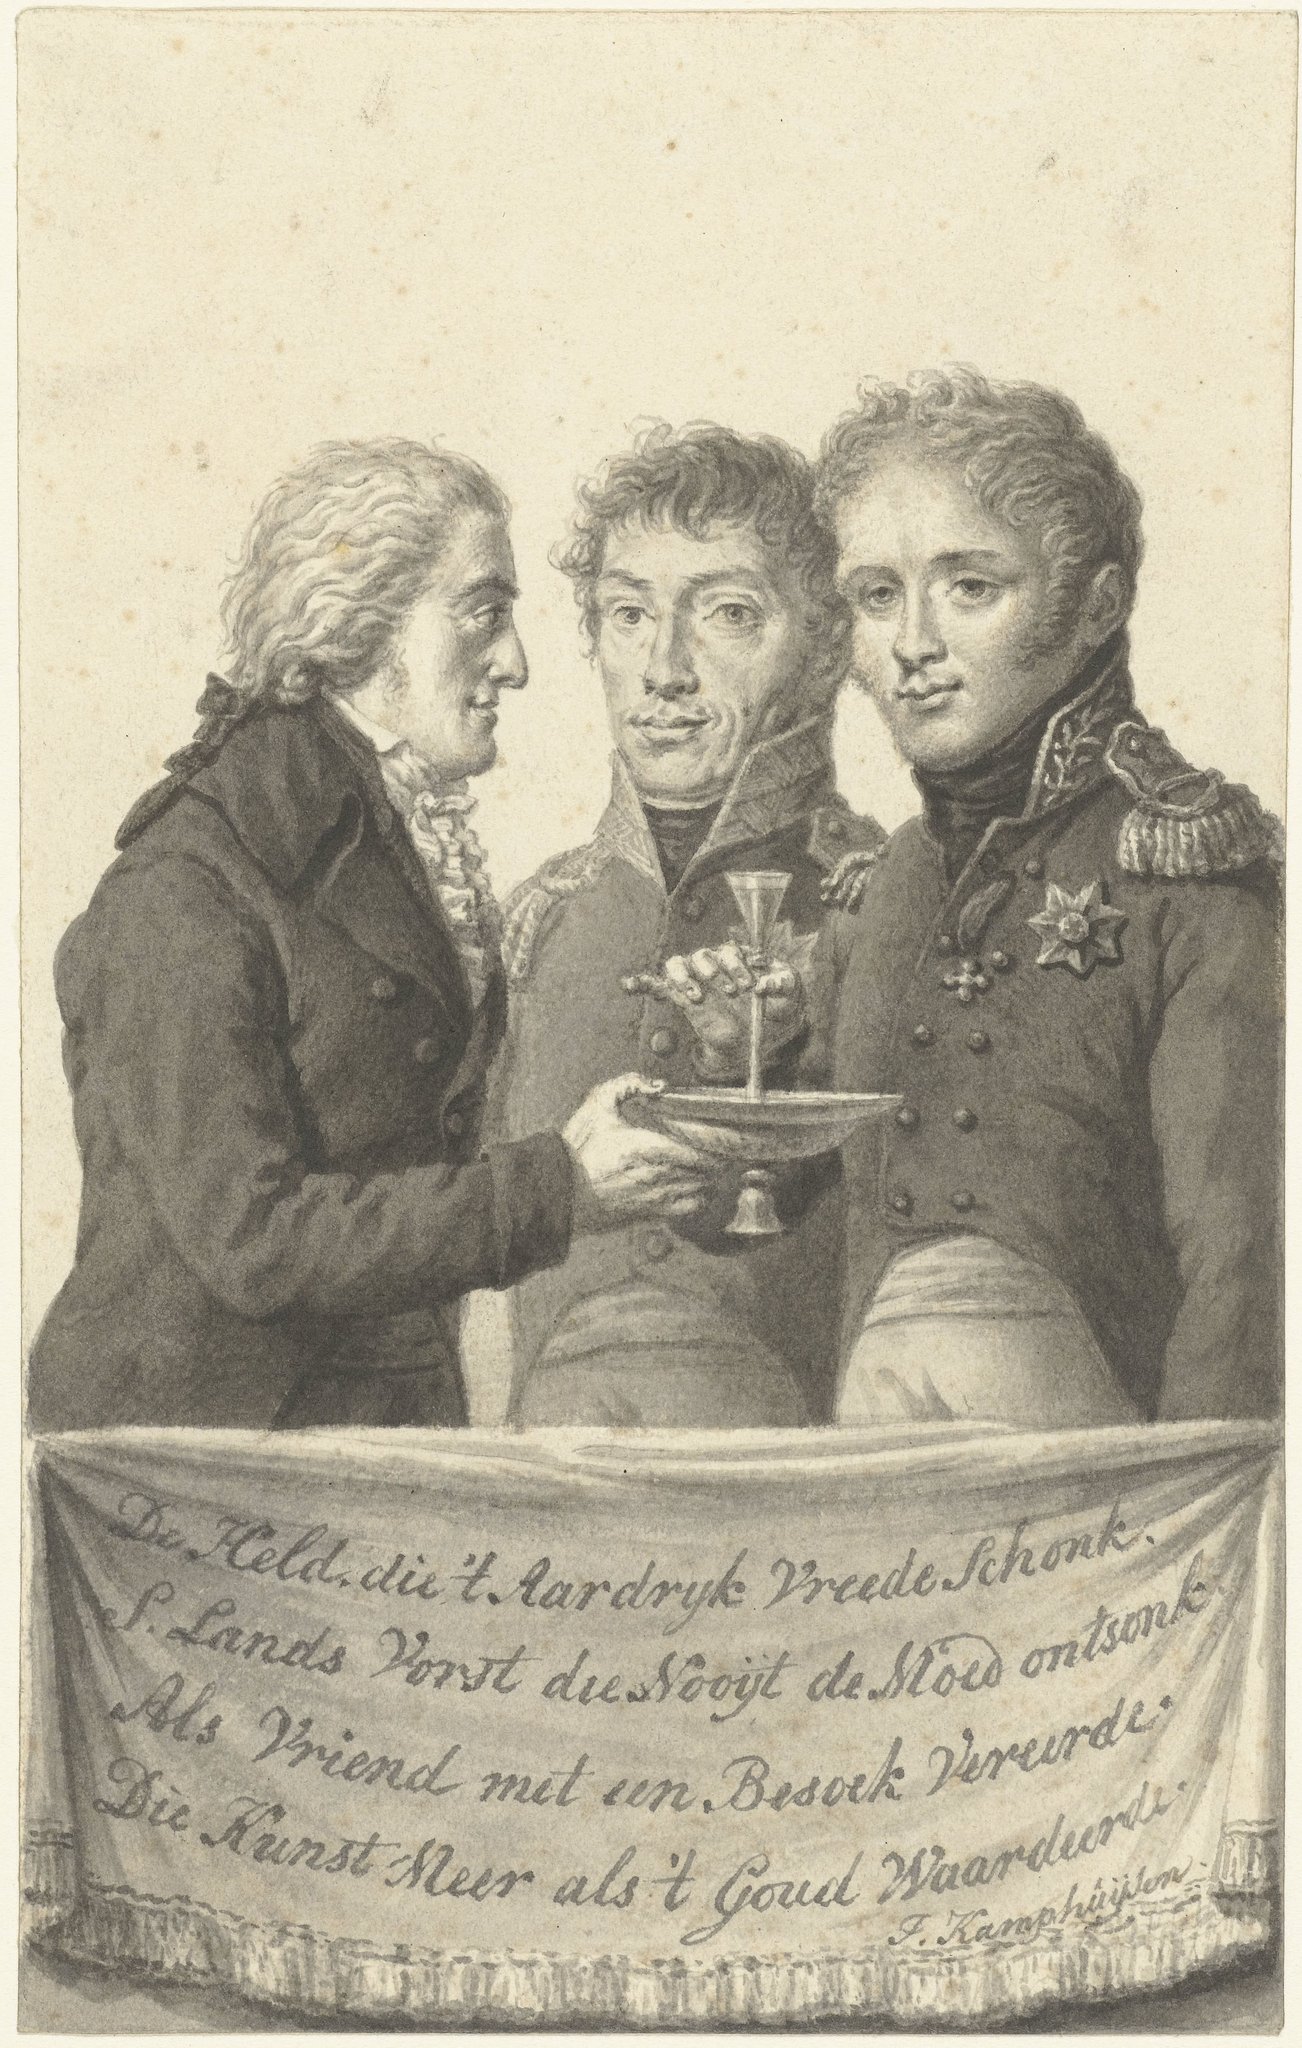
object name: drawing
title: A.J. Brentano biedt tsaar Alexander I een dronk aan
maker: jan kamphuijsen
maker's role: draughtsman, painter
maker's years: 1760-1841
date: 1814-1841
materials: ink, paper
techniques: brush, pen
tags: the hague, berlin, william i of the netherlands, alexander i (tsaar van rusland), historical persons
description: A.J. Brentano biedt tsaar Alexander I een dronk aan; in het midden ziet Koning Willem I toe.